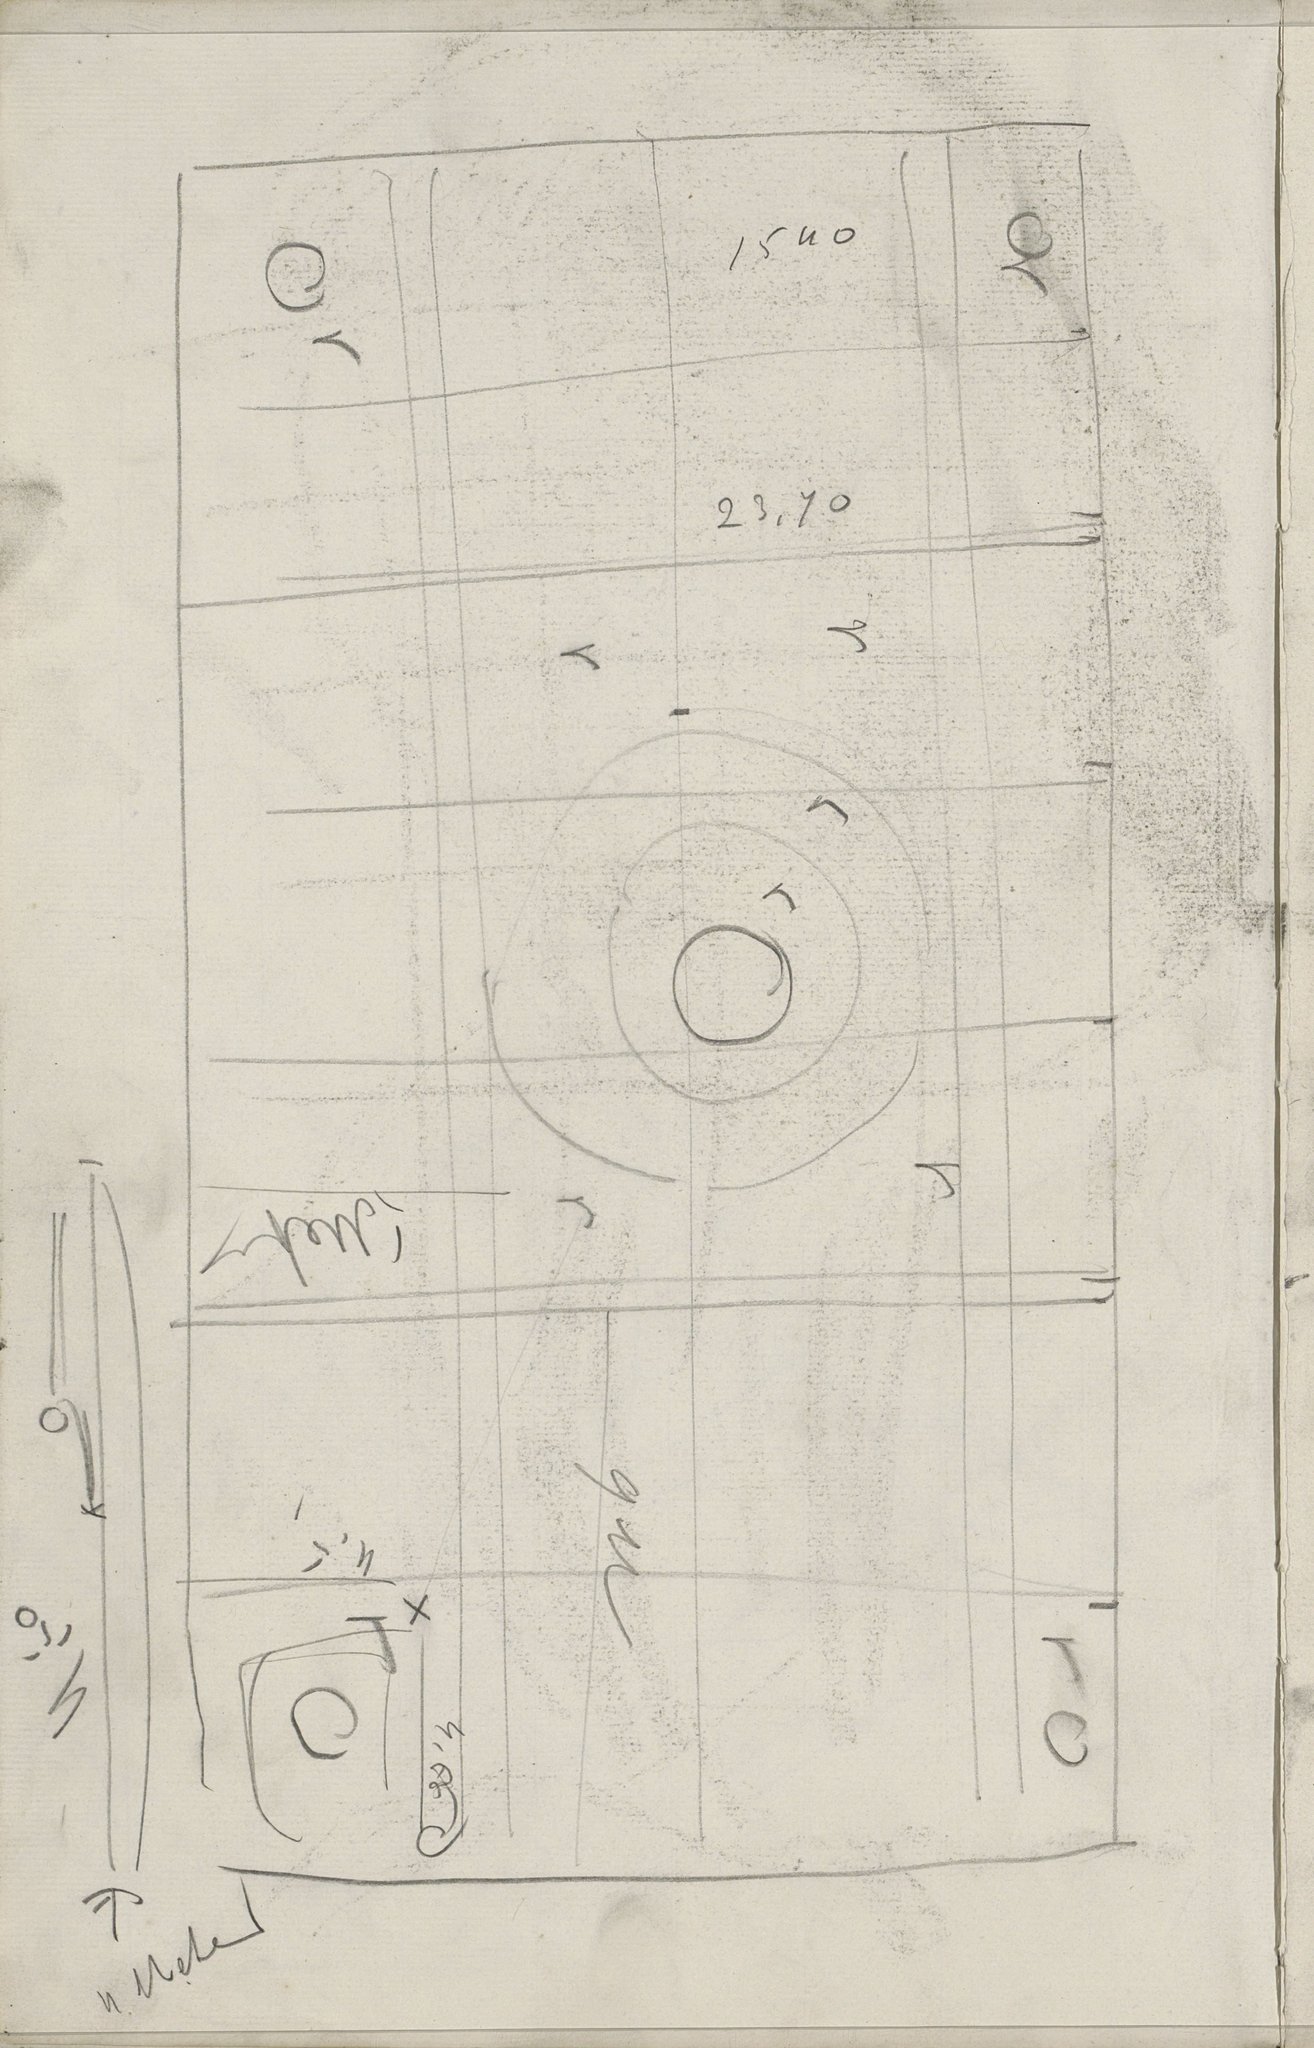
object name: sketchbook leaf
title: Concentrische cirkels in een raster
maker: carel adolph lion cachet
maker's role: draughtsman, print maker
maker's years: 1864-1945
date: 1895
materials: paper, pencil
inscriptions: annotation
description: Blad 8 verso uit een schetsboek met 23 bladen.